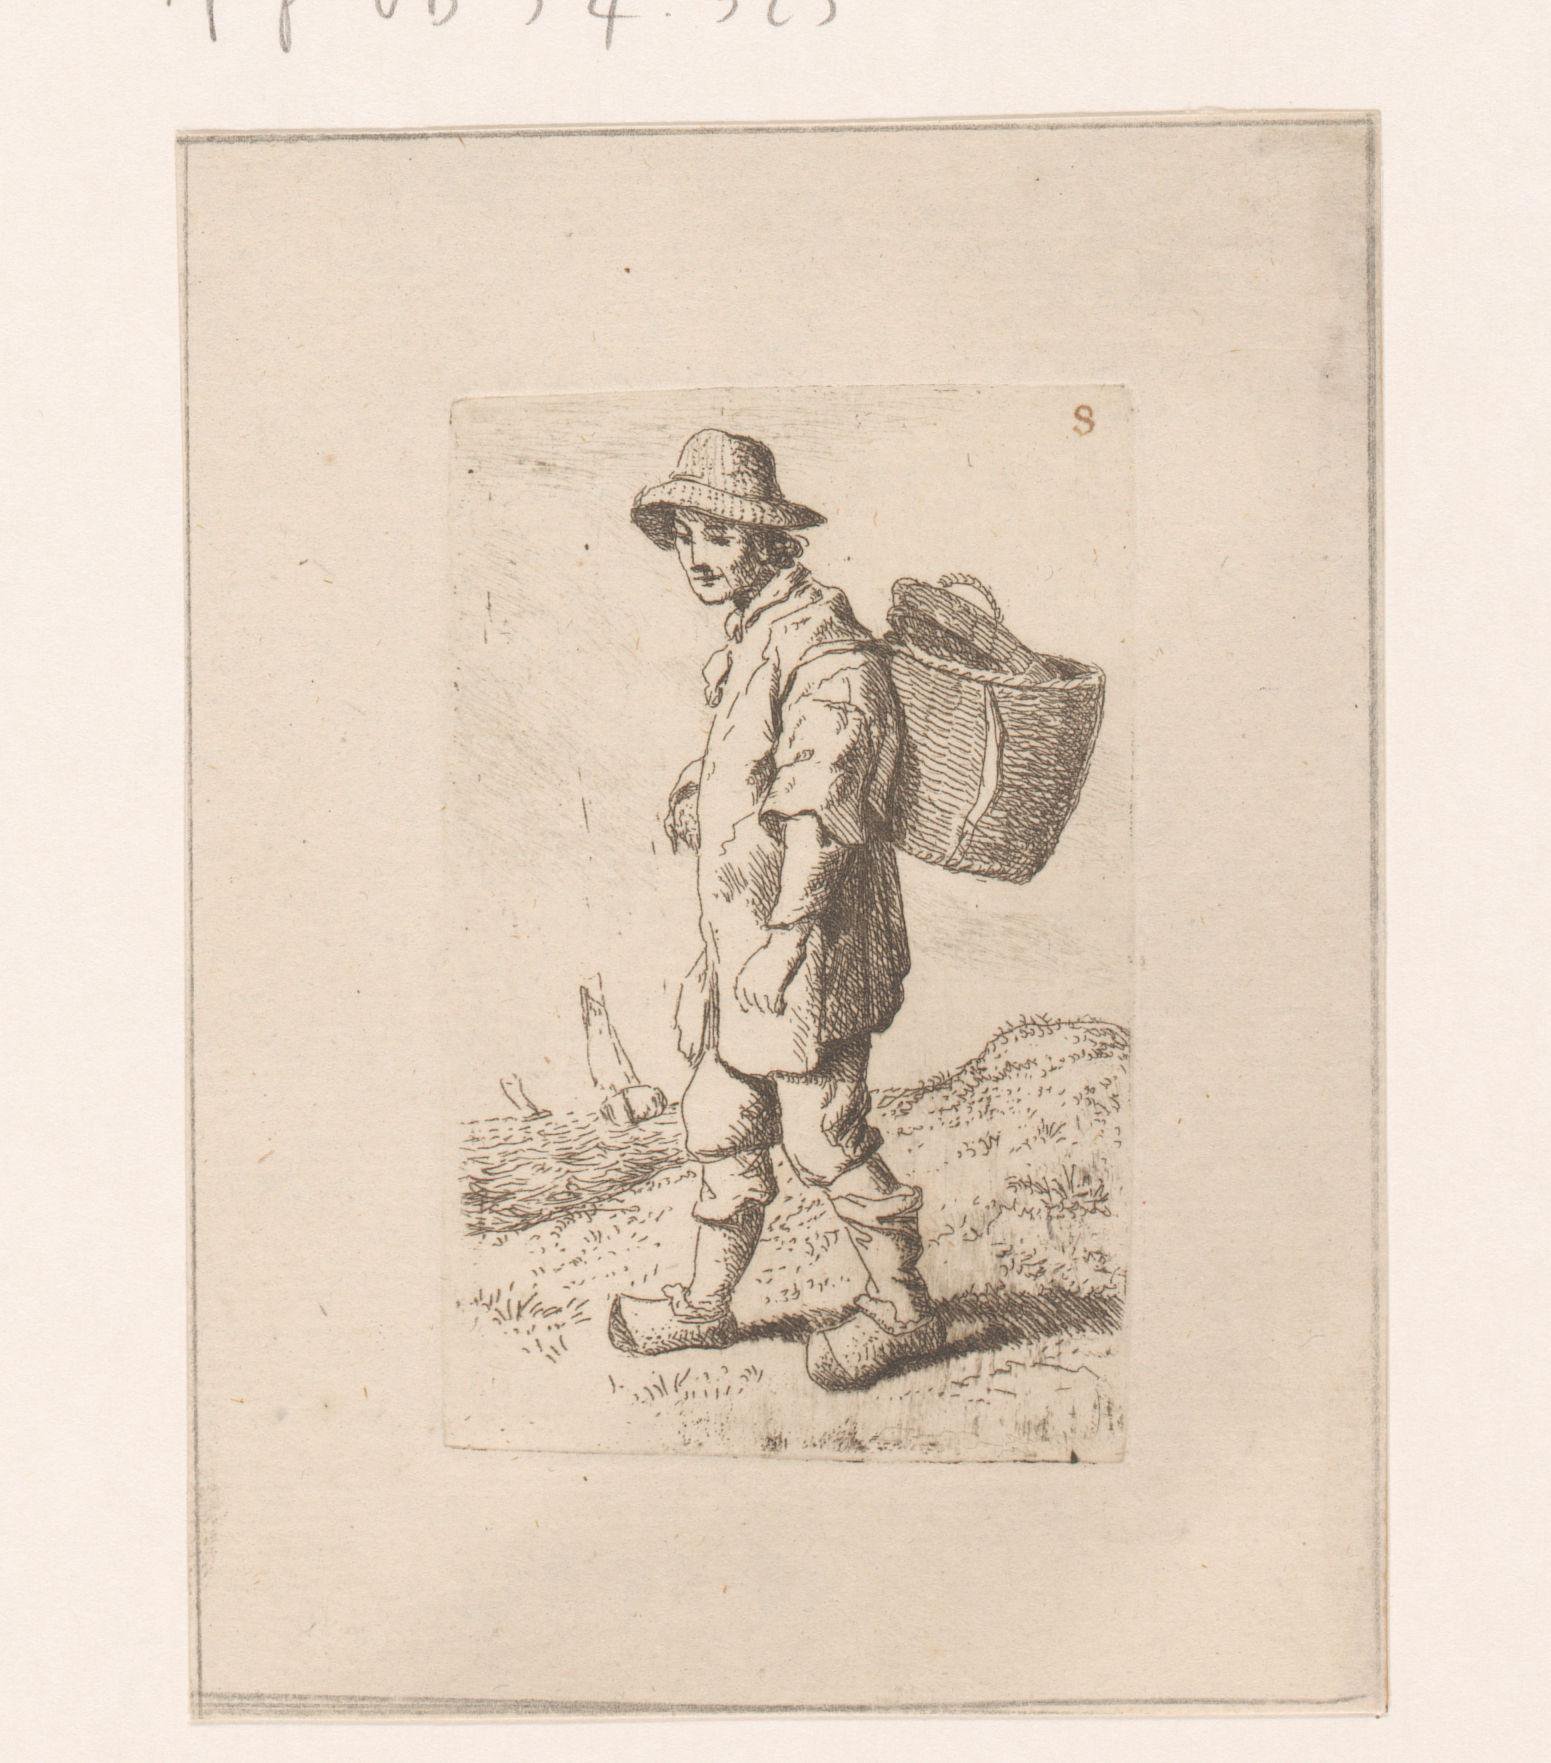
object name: print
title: Boeren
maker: hendrik willem schweickhardt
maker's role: draughtsman, painter, print maker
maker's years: 1746-1797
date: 1756-1797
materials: paper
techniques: etching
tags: farmers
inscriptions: number: ‘8’, collector's mark: Lugt 240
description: Behoort tot een serie van acht prenten met boeren.